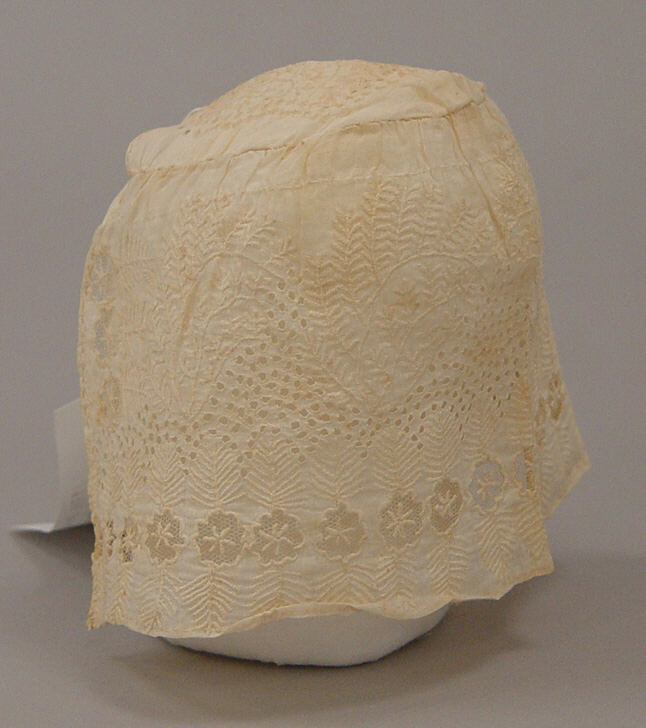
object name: cap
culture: american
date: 1800-1850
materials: cotton